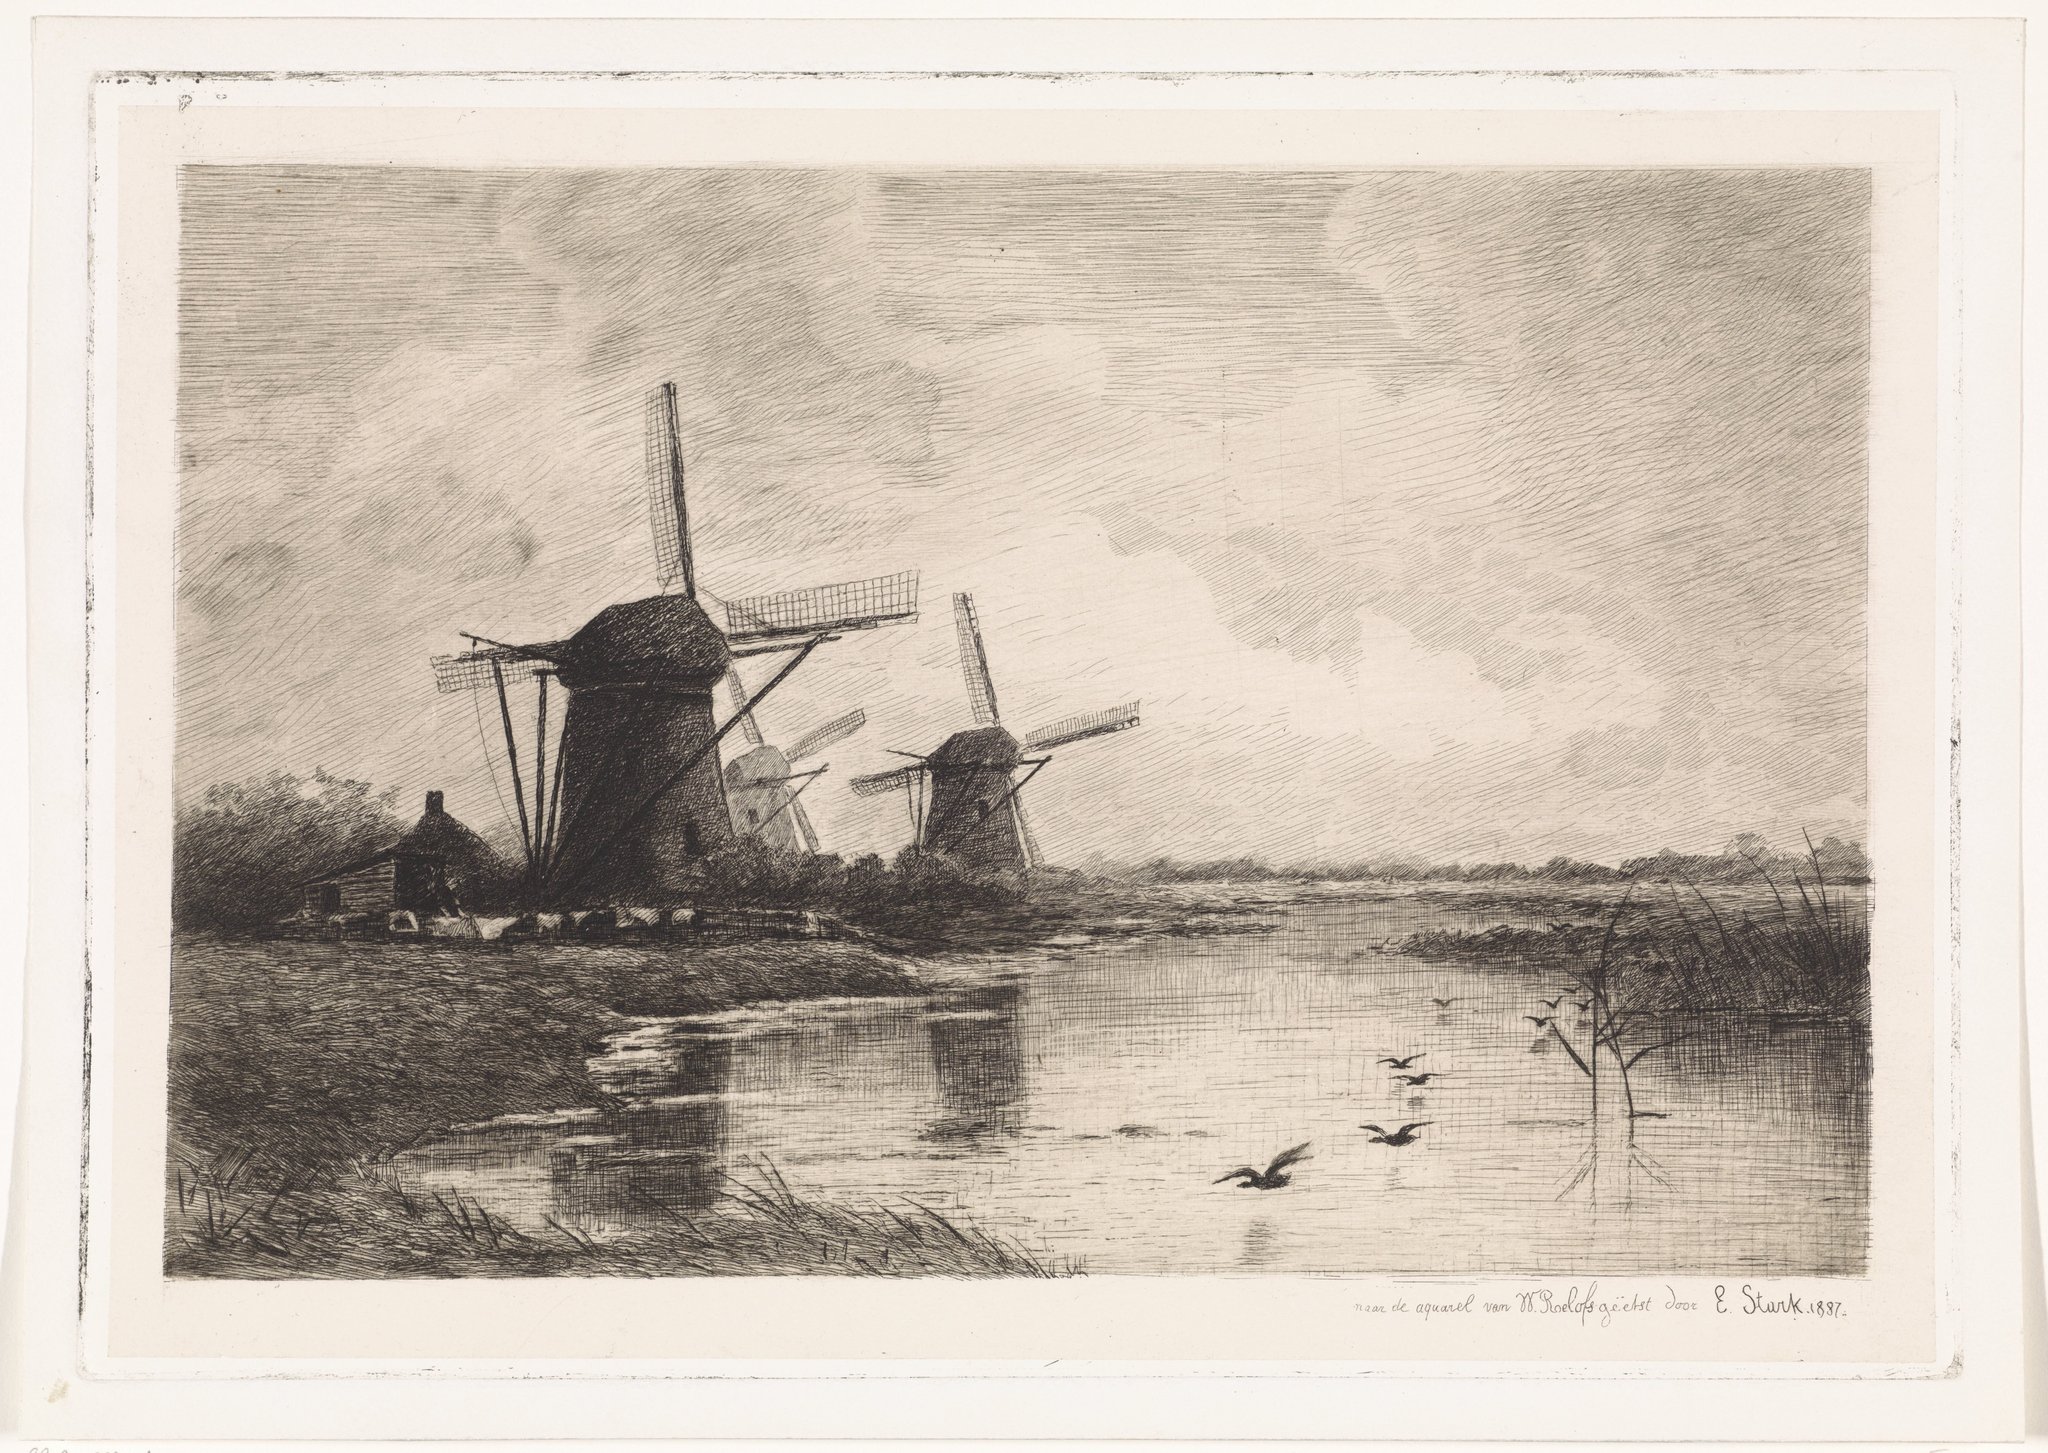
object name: print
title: Landschap met drie molens langs een vaart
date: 1887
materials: paper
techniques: etching, roulette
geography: nieuwer-amstel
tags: canal, windmill in landscape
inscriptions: collector's mark: Lugt 2228